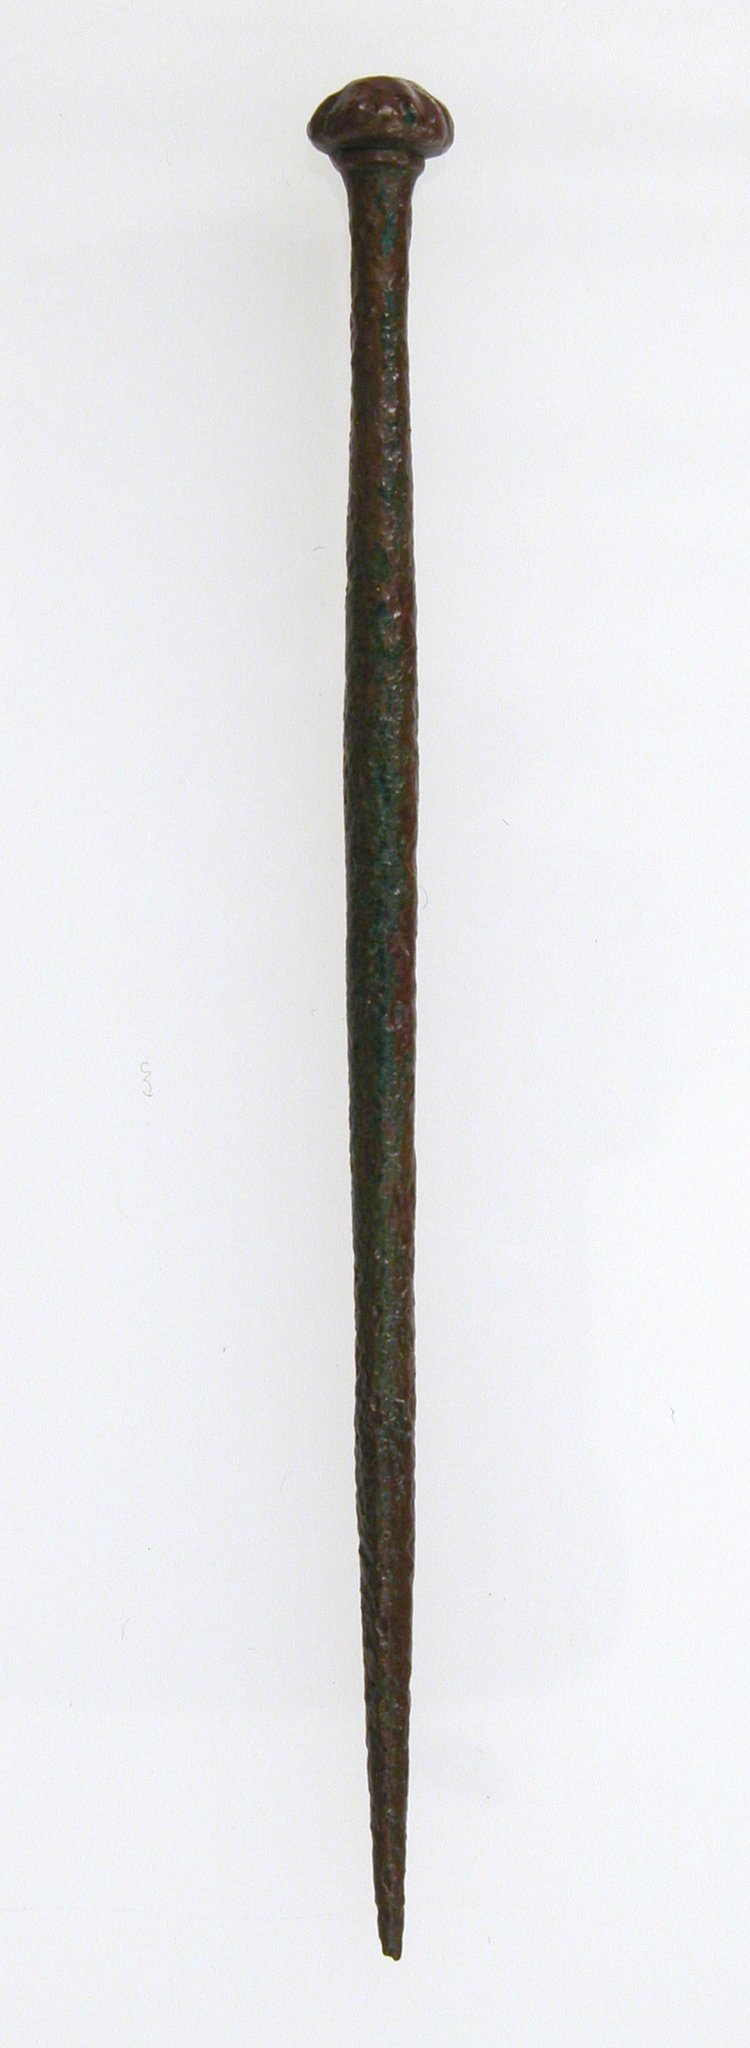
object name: pin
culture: irish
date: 901-1000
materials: copper alloy